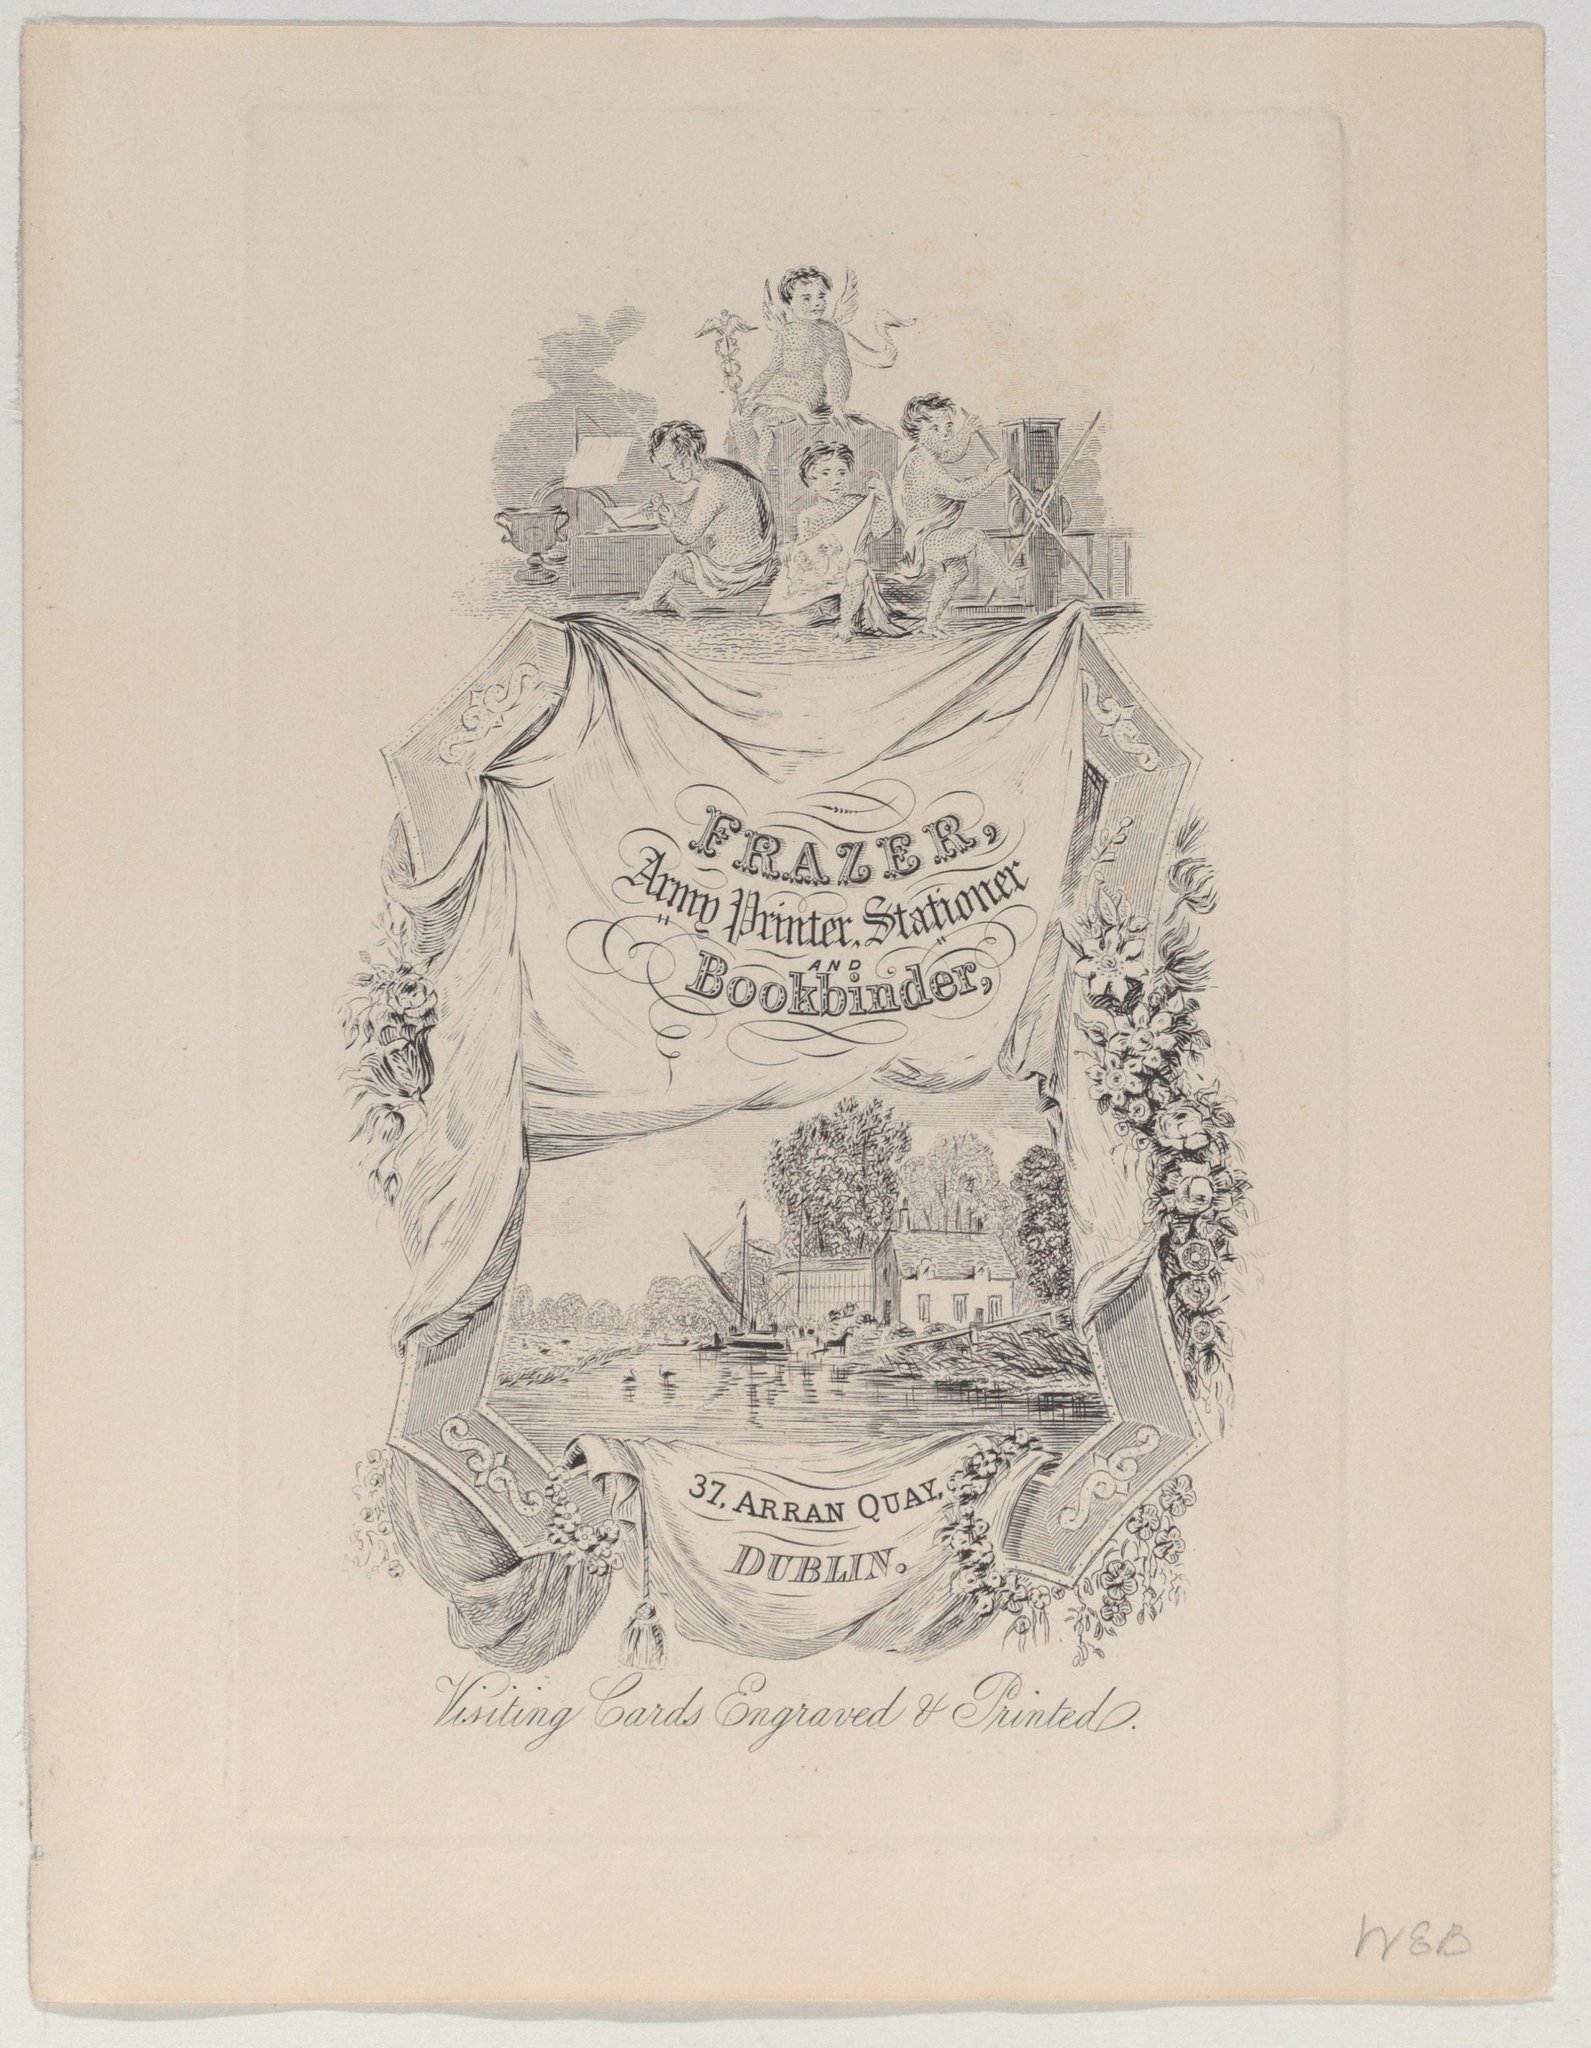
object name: print, trade card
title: Trade Card for Frazer, Army Printer, Stationer and Bookbinder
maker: anonymous, irish, 19th century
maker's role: artist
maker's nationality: irish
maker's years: 1800-1900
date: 1801-1900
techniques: engraving